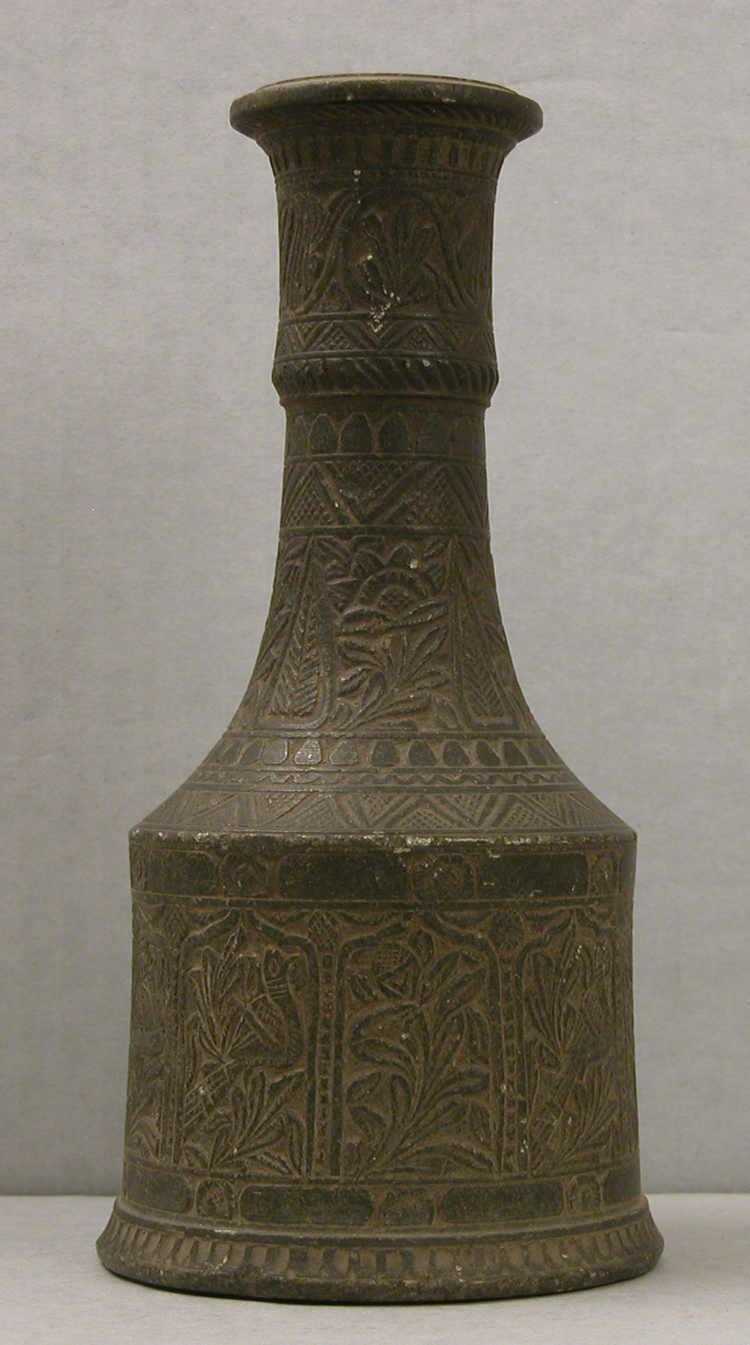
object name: vase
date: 1801-1900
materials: stone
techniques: carving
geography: iran